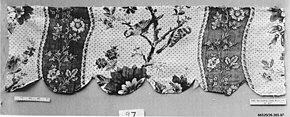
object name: floral print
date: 1785-1790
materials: linen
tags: birds,flowers